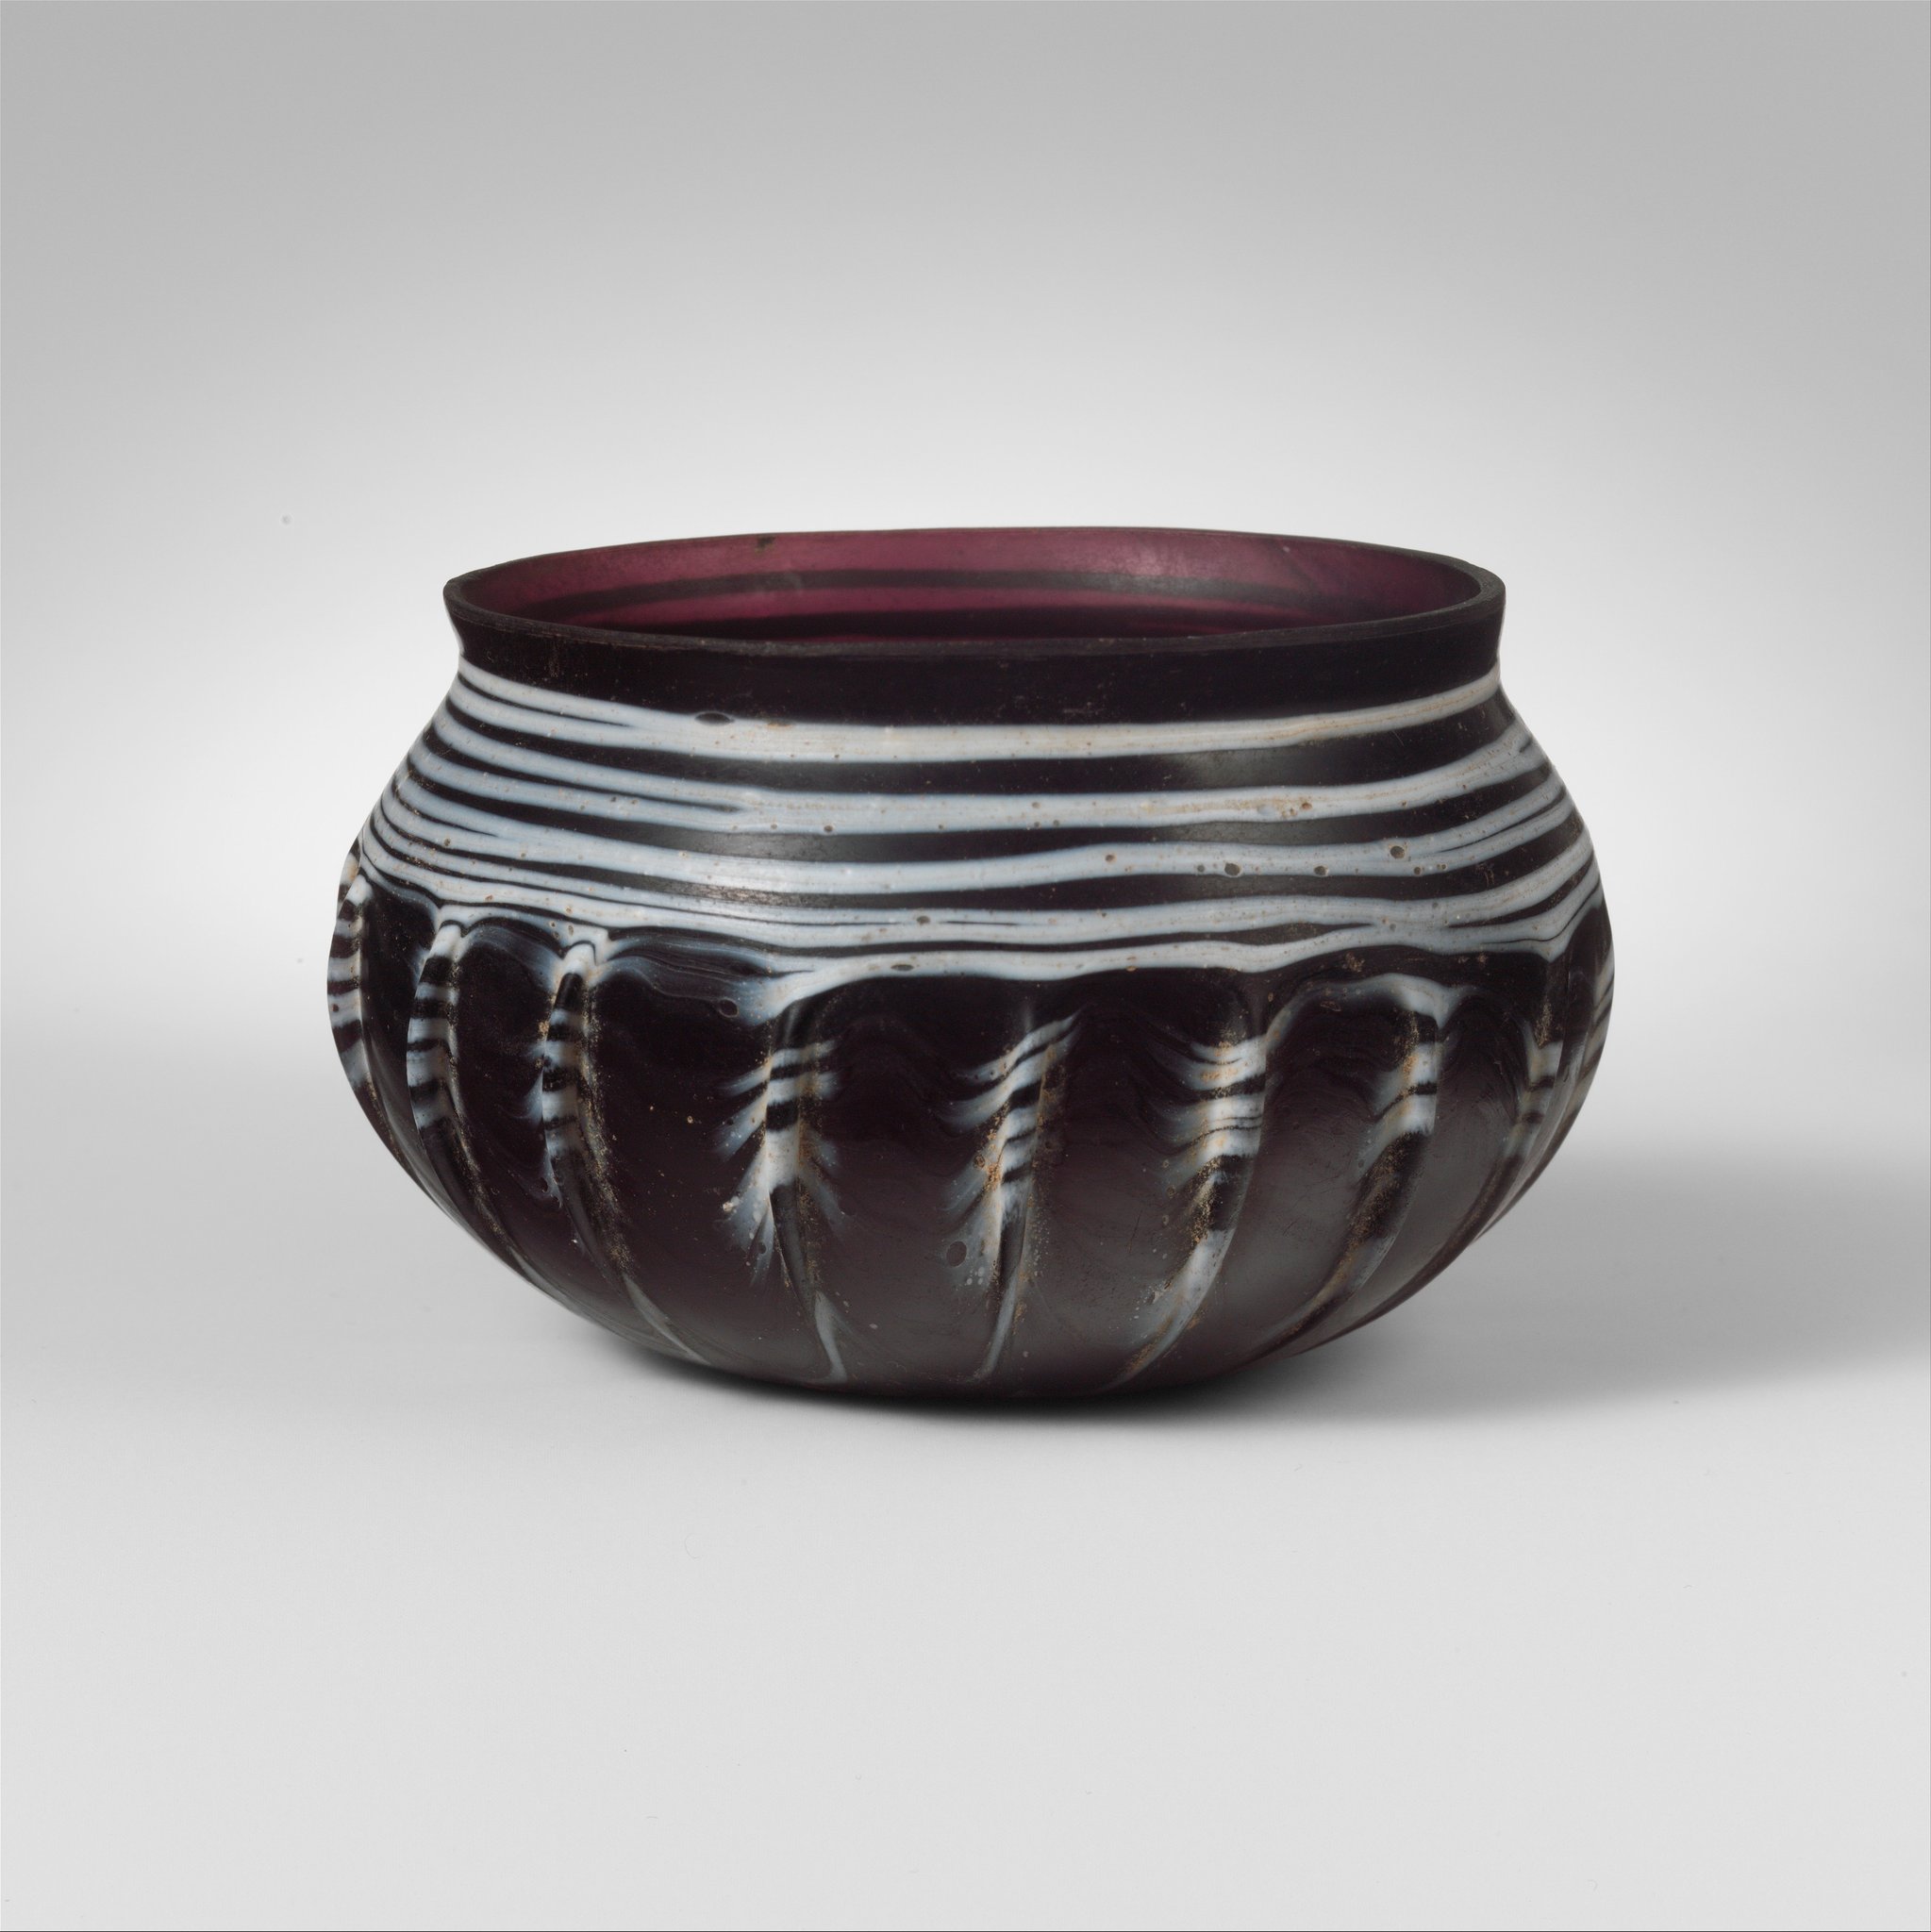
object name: bowl, rippenschale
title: Glass ribbed bowl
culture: roman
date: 34-66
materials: glass